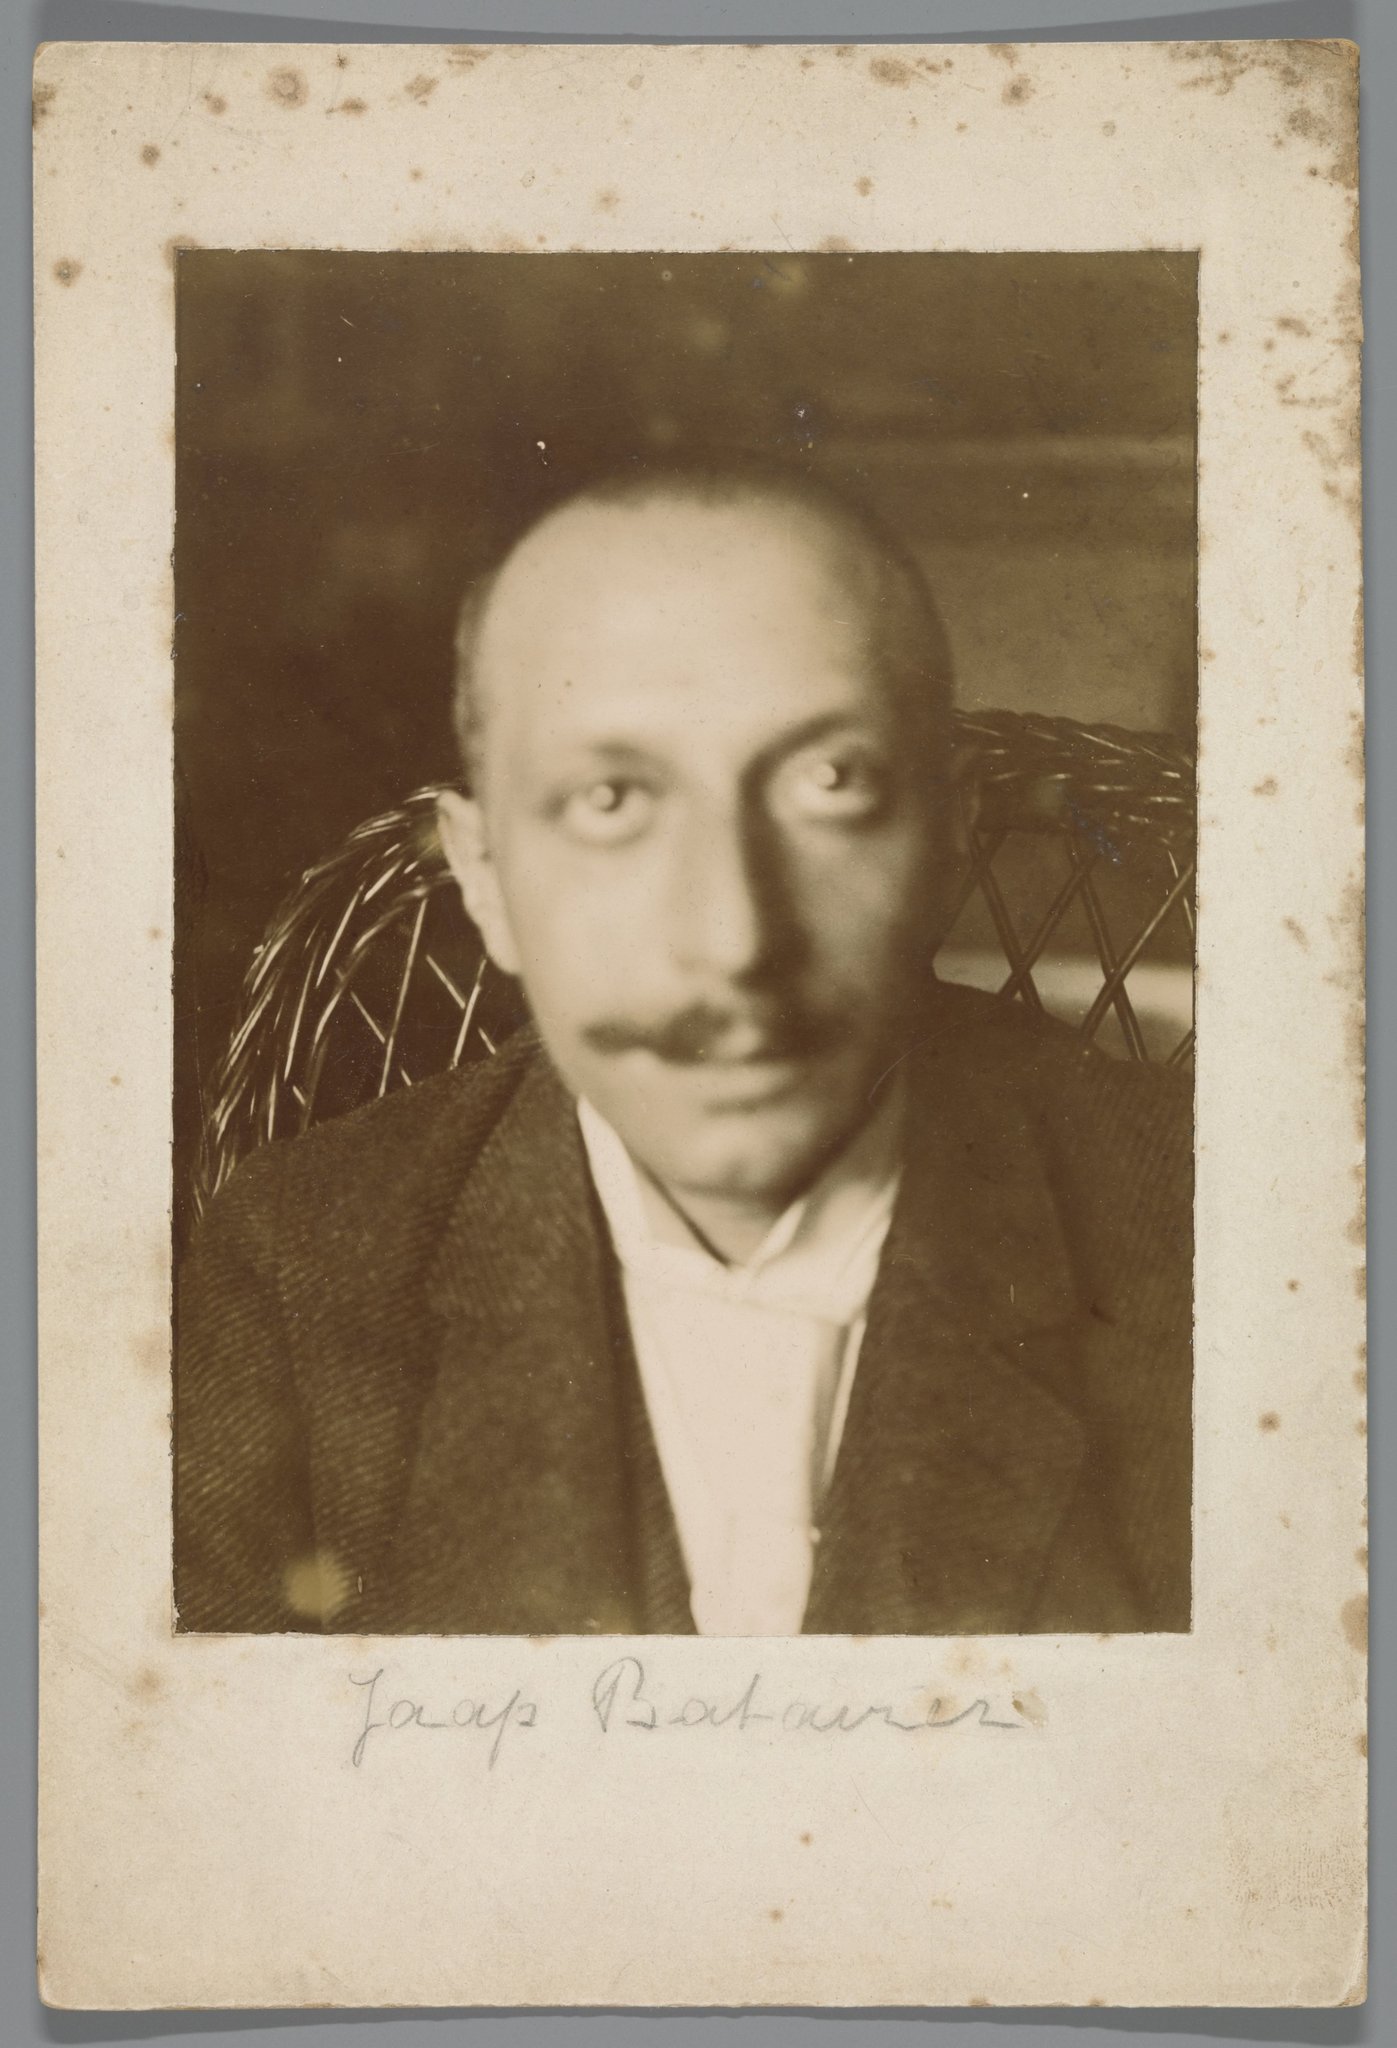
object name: photograph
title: Portraits of Lise Jordan, George Hendrik Breitner, Lise Jordan, Jaap Batavier, Hein Boeken, Paul Verlaine and Herman Gorter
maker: willem witsen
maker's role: draughtsman, painter, print maker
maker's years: 1860-1923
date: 1891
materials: cardboard, paper, photographic support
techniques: gelatin silver print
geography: amsterdam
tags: amersfoort, jacob batavier (jaap)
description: Witsen was a painter, etcher, and engraver of Amsterdam city views. The writers known as De Tachtigers (Literary Movement of Eighteen Eighties) and the artists’ models Marie and Lise Jordan met in his studio. In his free time Witsen photographed his friends in a way he had cribbed from Joseph Jessurun de Mesquita, who died young. He experimented endlessly, for instance with heads filling the picture plane and seen close up. He also managed to convince the French poet Verlaine to pose in front of his camera.